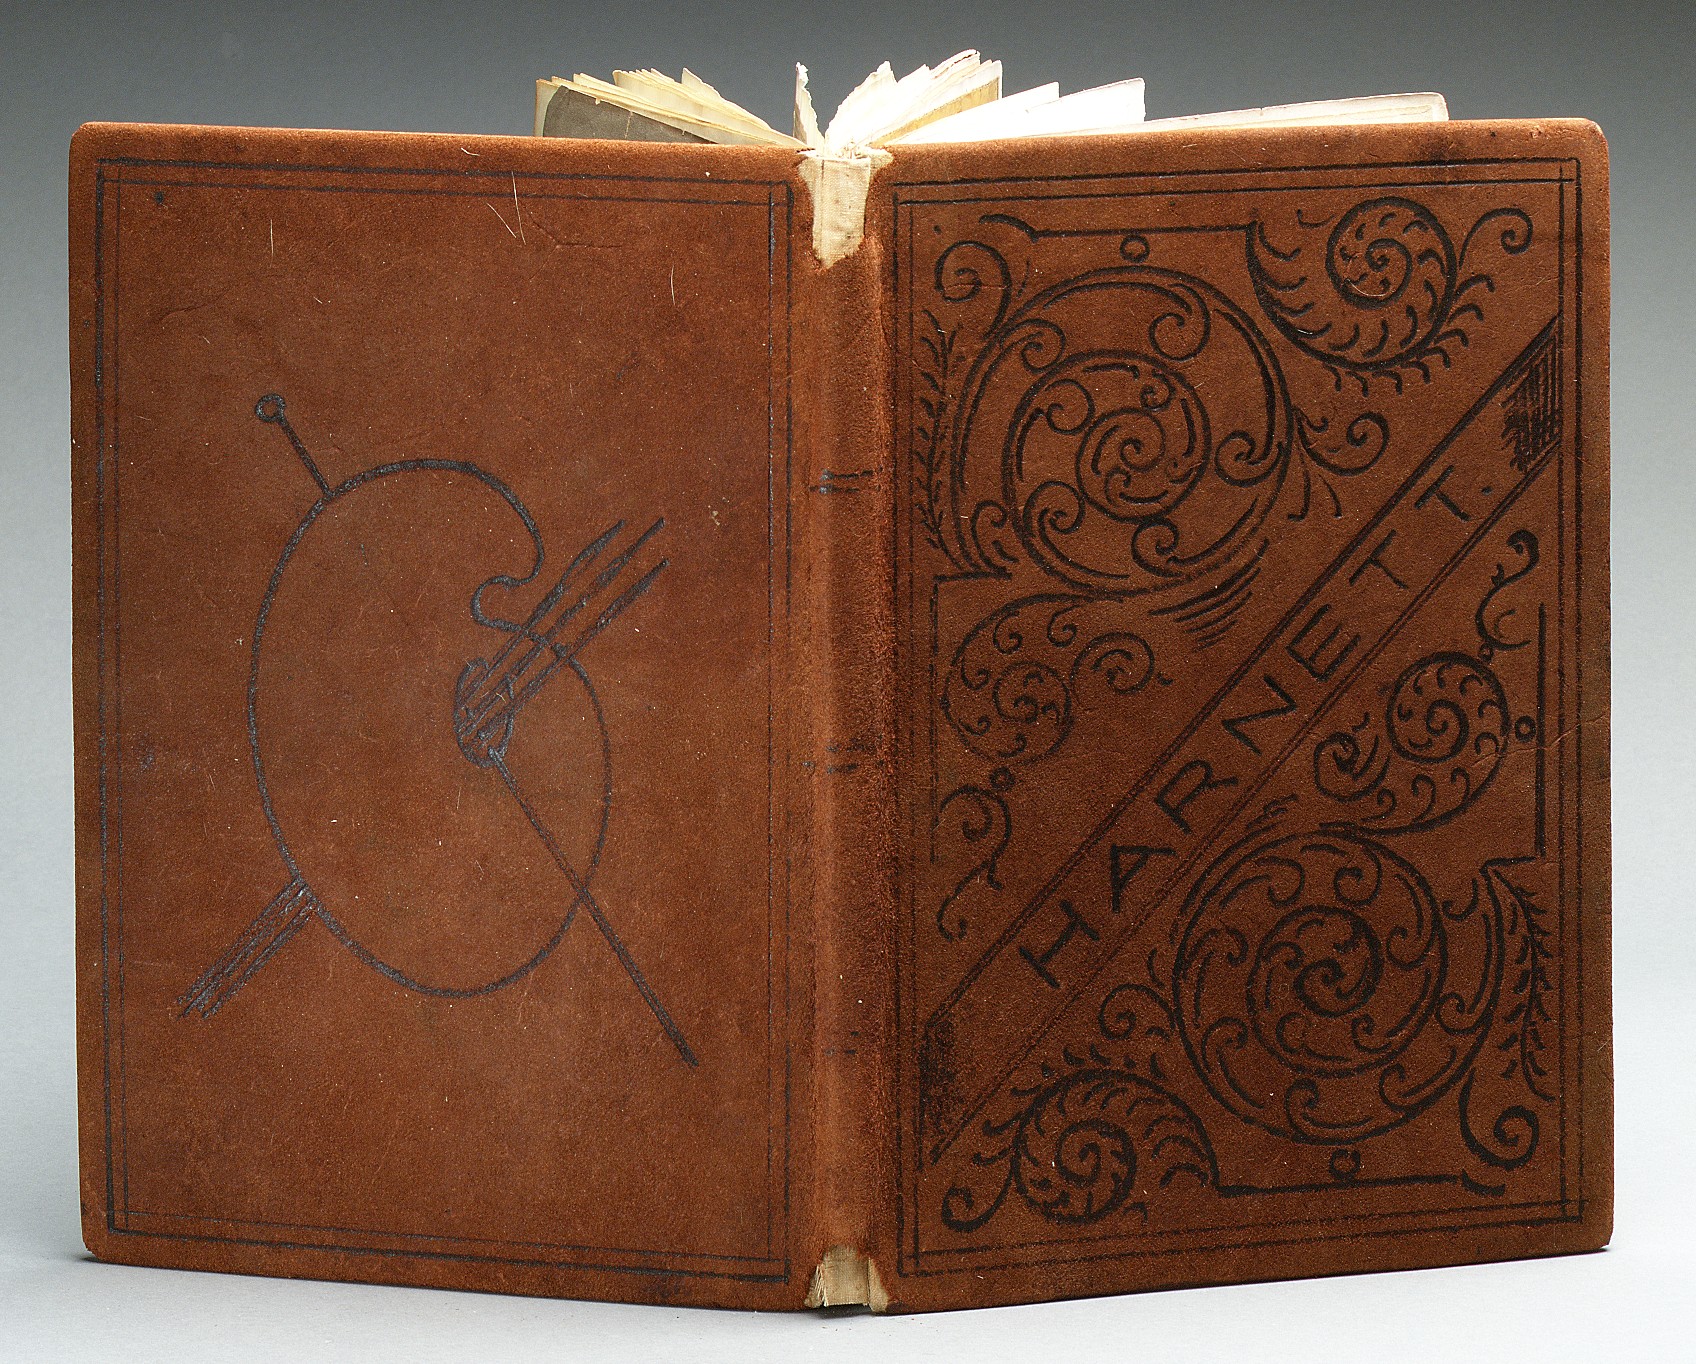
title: Scrapbook containing newspaper and magazine clippings, calling cards, sketches, photographs of paintings, and two sales catalogs of Harnett's (William Michael Harnett, 1848–1892) work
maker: william ignatius blemly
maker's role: author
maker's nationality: american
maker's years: 18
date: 1848-1900